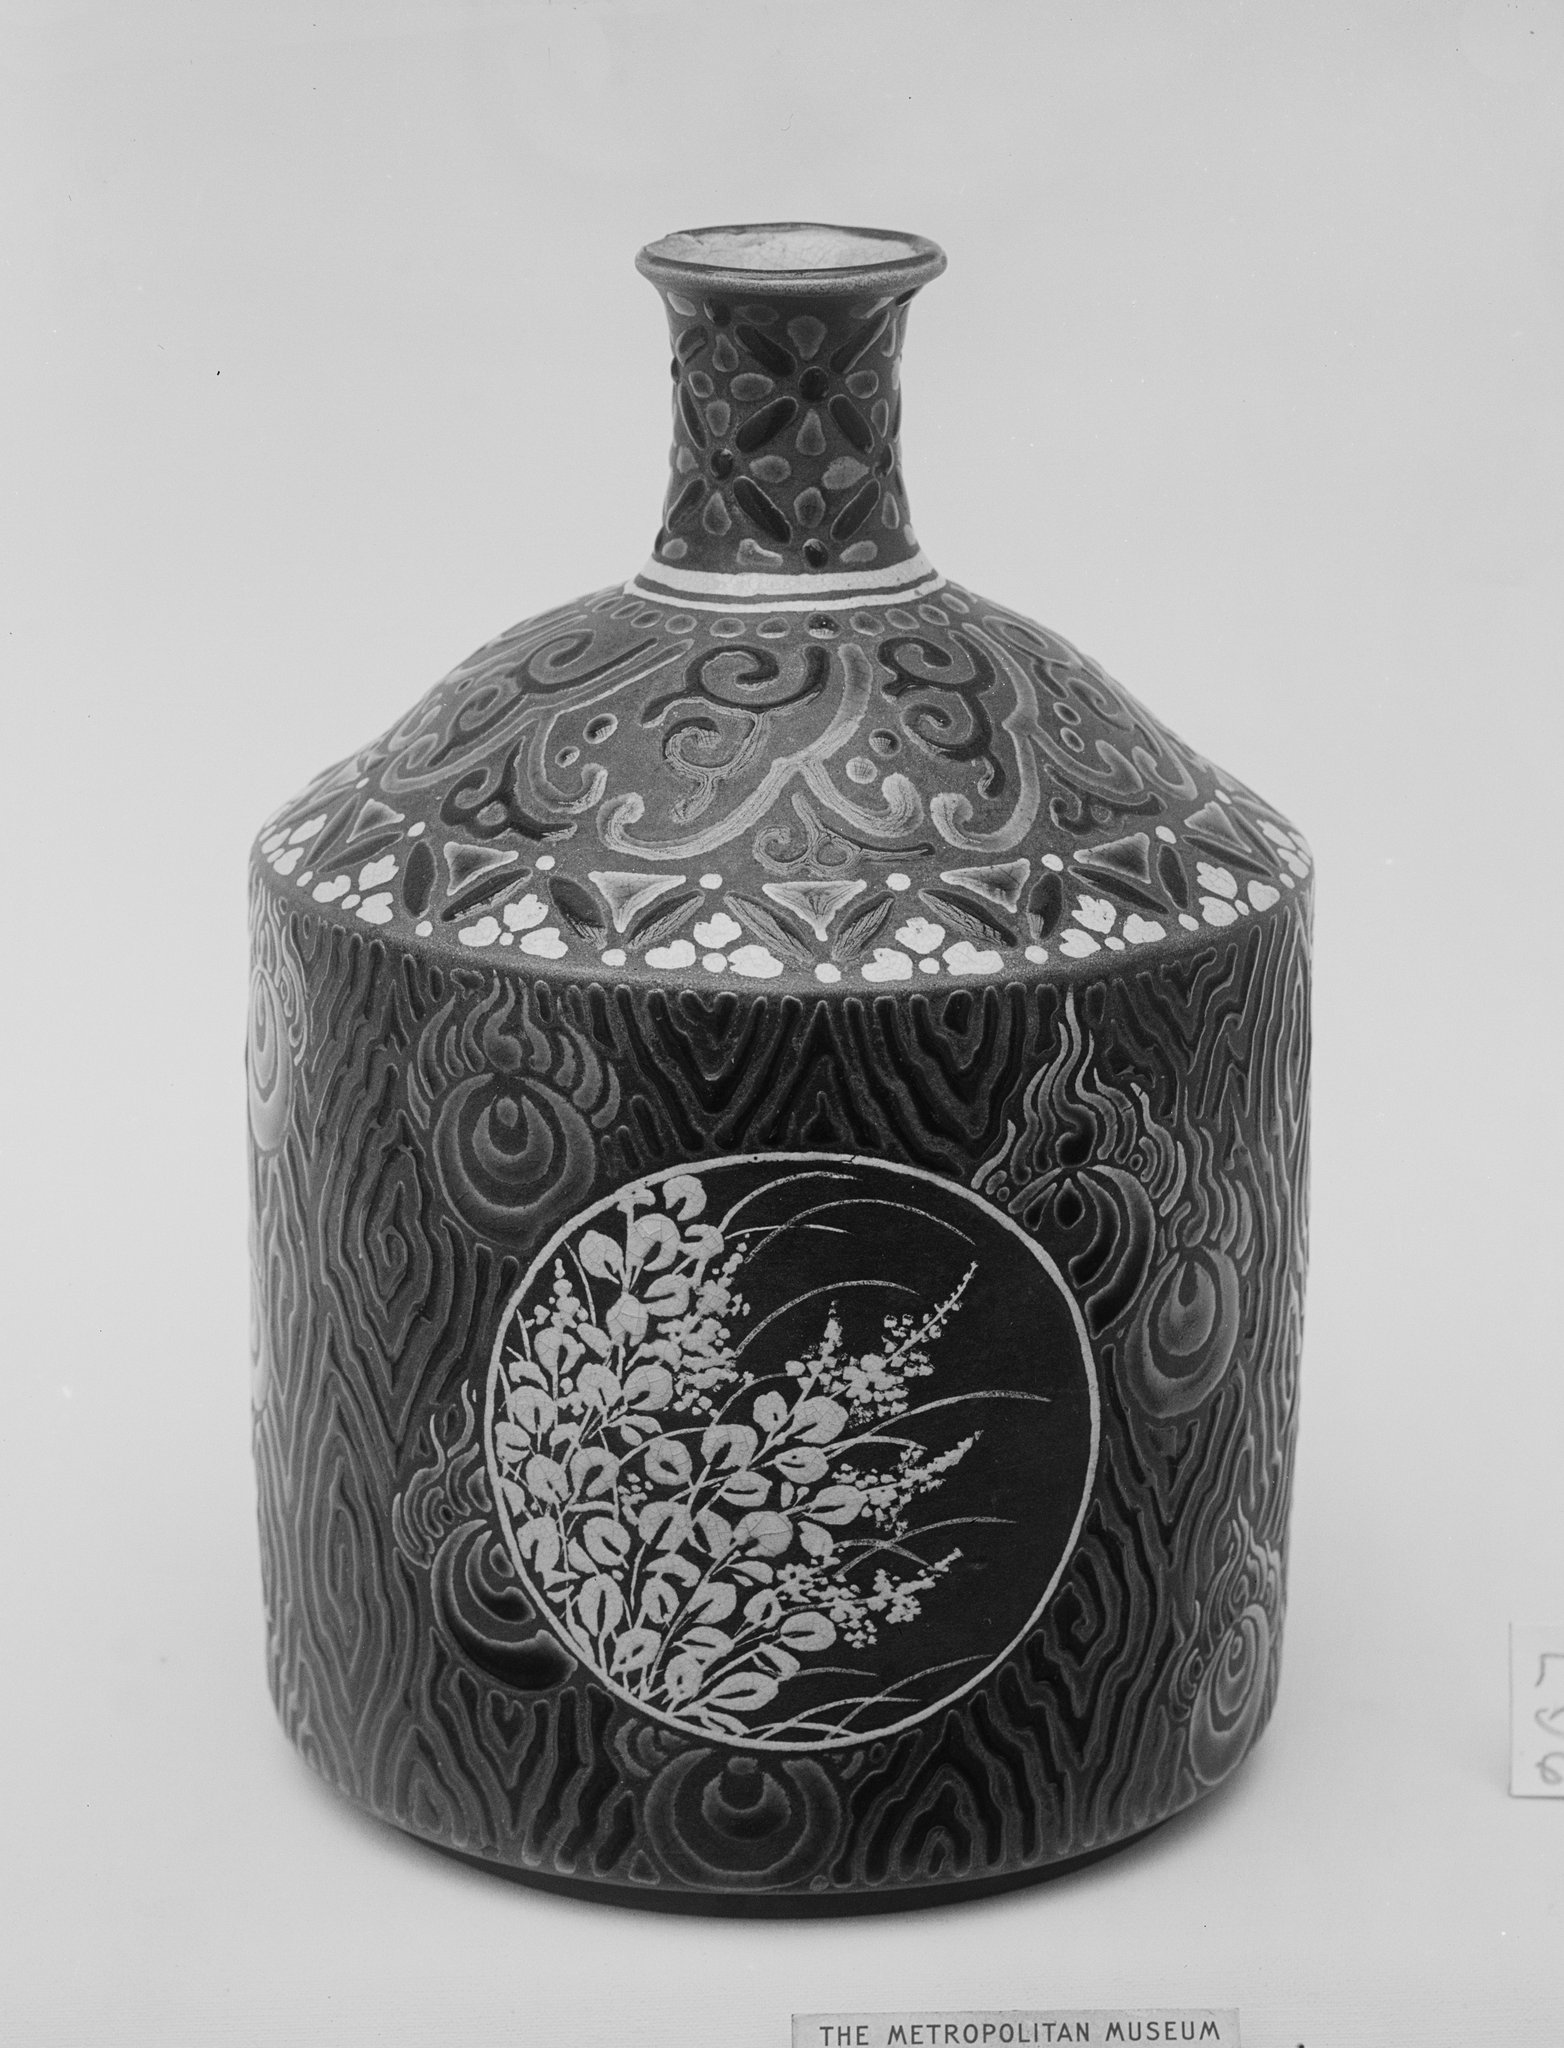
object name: wine bottle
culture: japanese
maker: hozan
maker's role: artist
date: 1730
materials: clay, enamel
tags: leaves